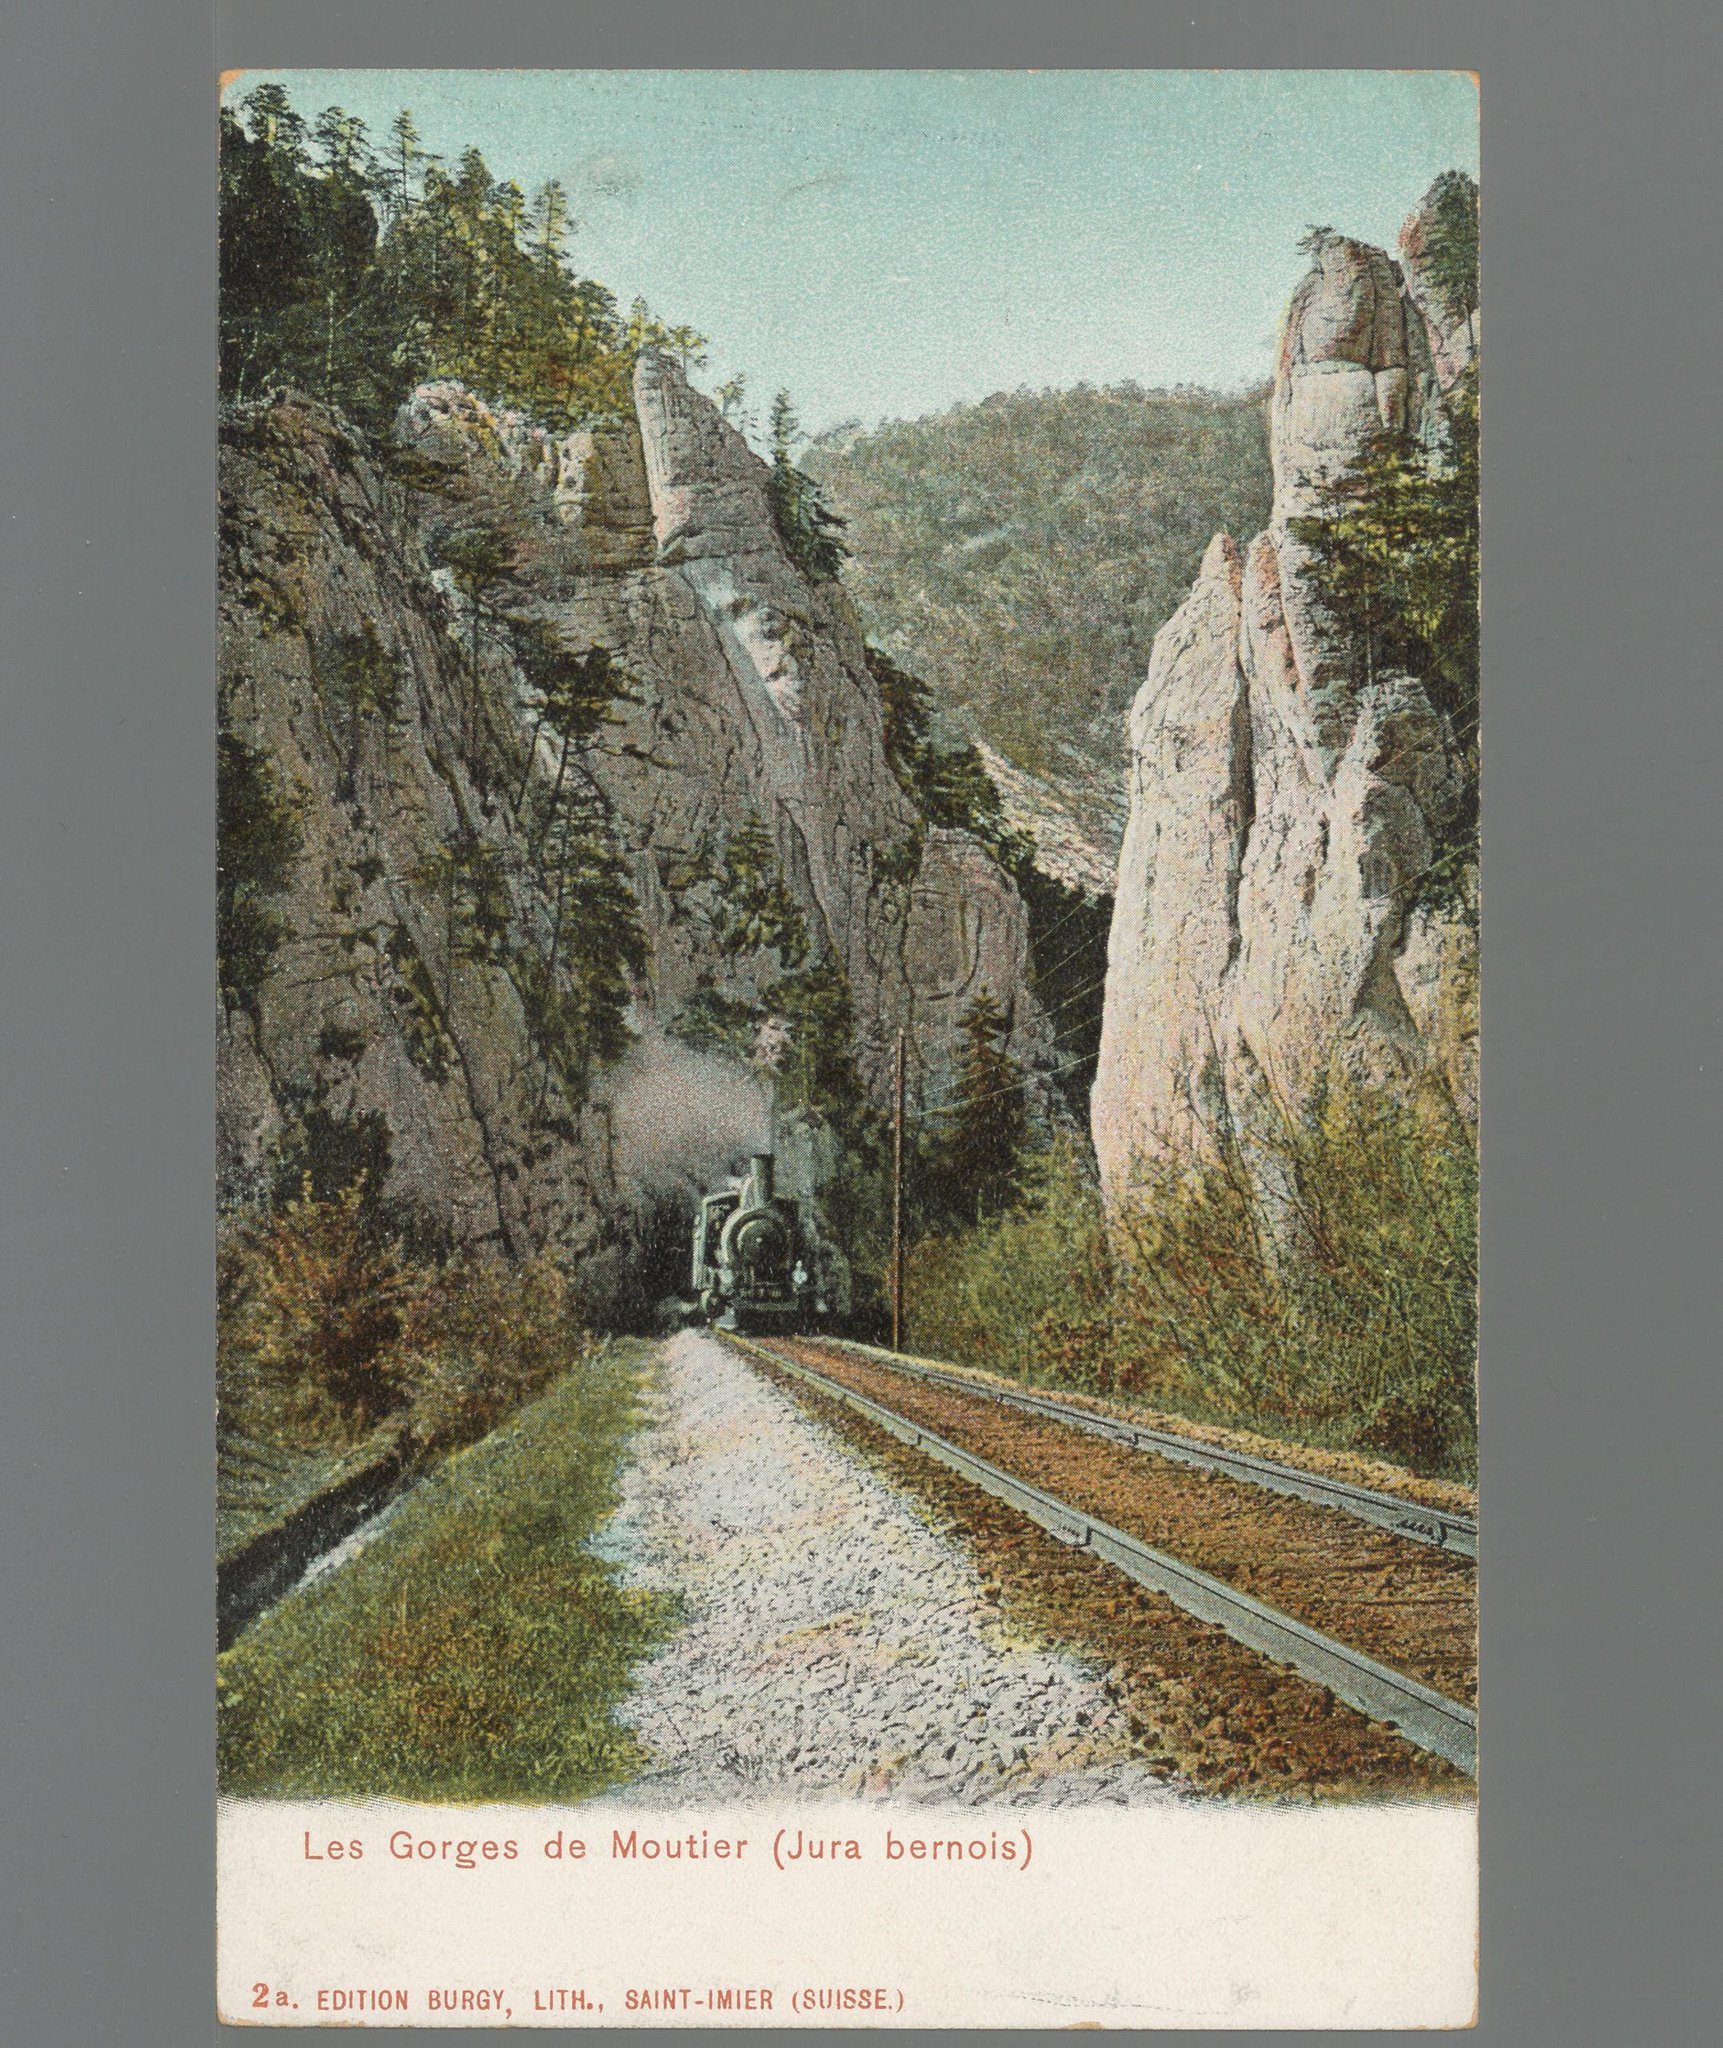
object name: ansichtkaart, prentbriefkaart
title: Les Gorges de Moutier (Jura bernois)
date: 1890-1905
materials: cardboard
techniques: lithograph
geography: moutier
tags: railway, train, underground road, tunnel, rock-formations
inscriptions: stamp